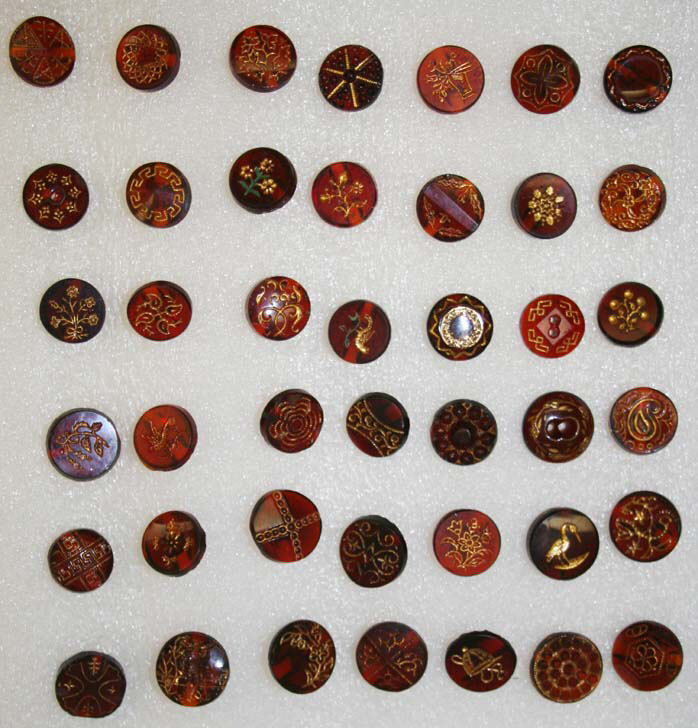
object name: button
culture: american or european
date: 1880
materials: glass